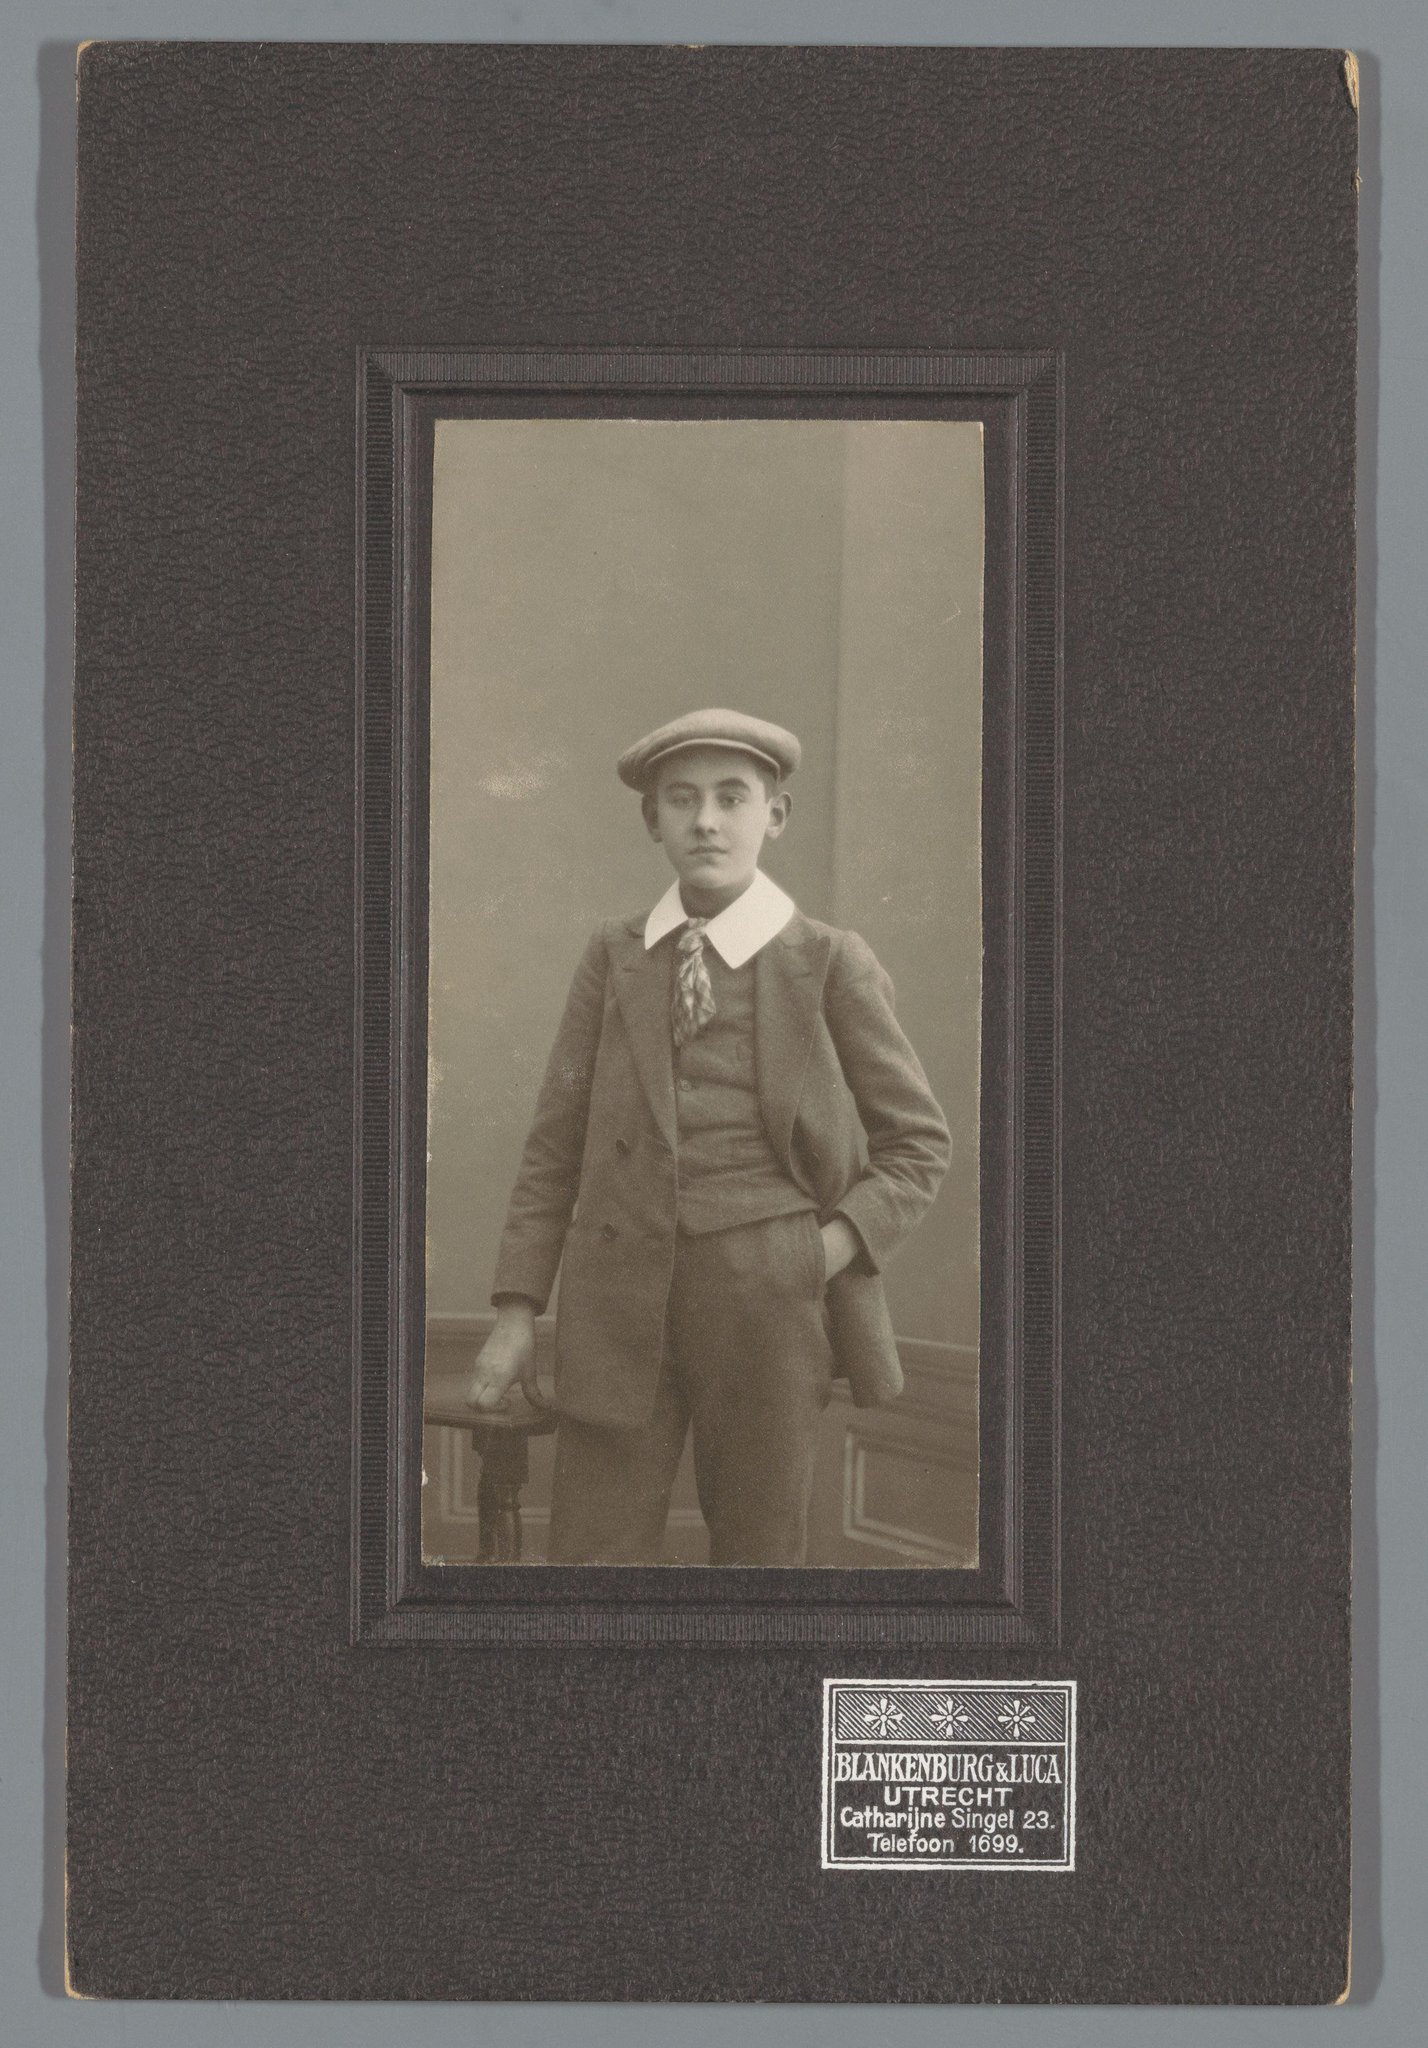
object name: cabinet photograph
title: Portret van Piet van Eijk, de jongere broer van G.N.P. van Eijk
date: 1910-1920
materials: paper, cardboard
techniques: gelatin silver print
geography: utrecht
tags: hand in the pocket, boy (child between toddler and youth), historical persons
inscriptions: inscription: ‘Blankenburg & Luca/ Utrecht/ Catharijne Singel 23./ Telefoon 1699.’